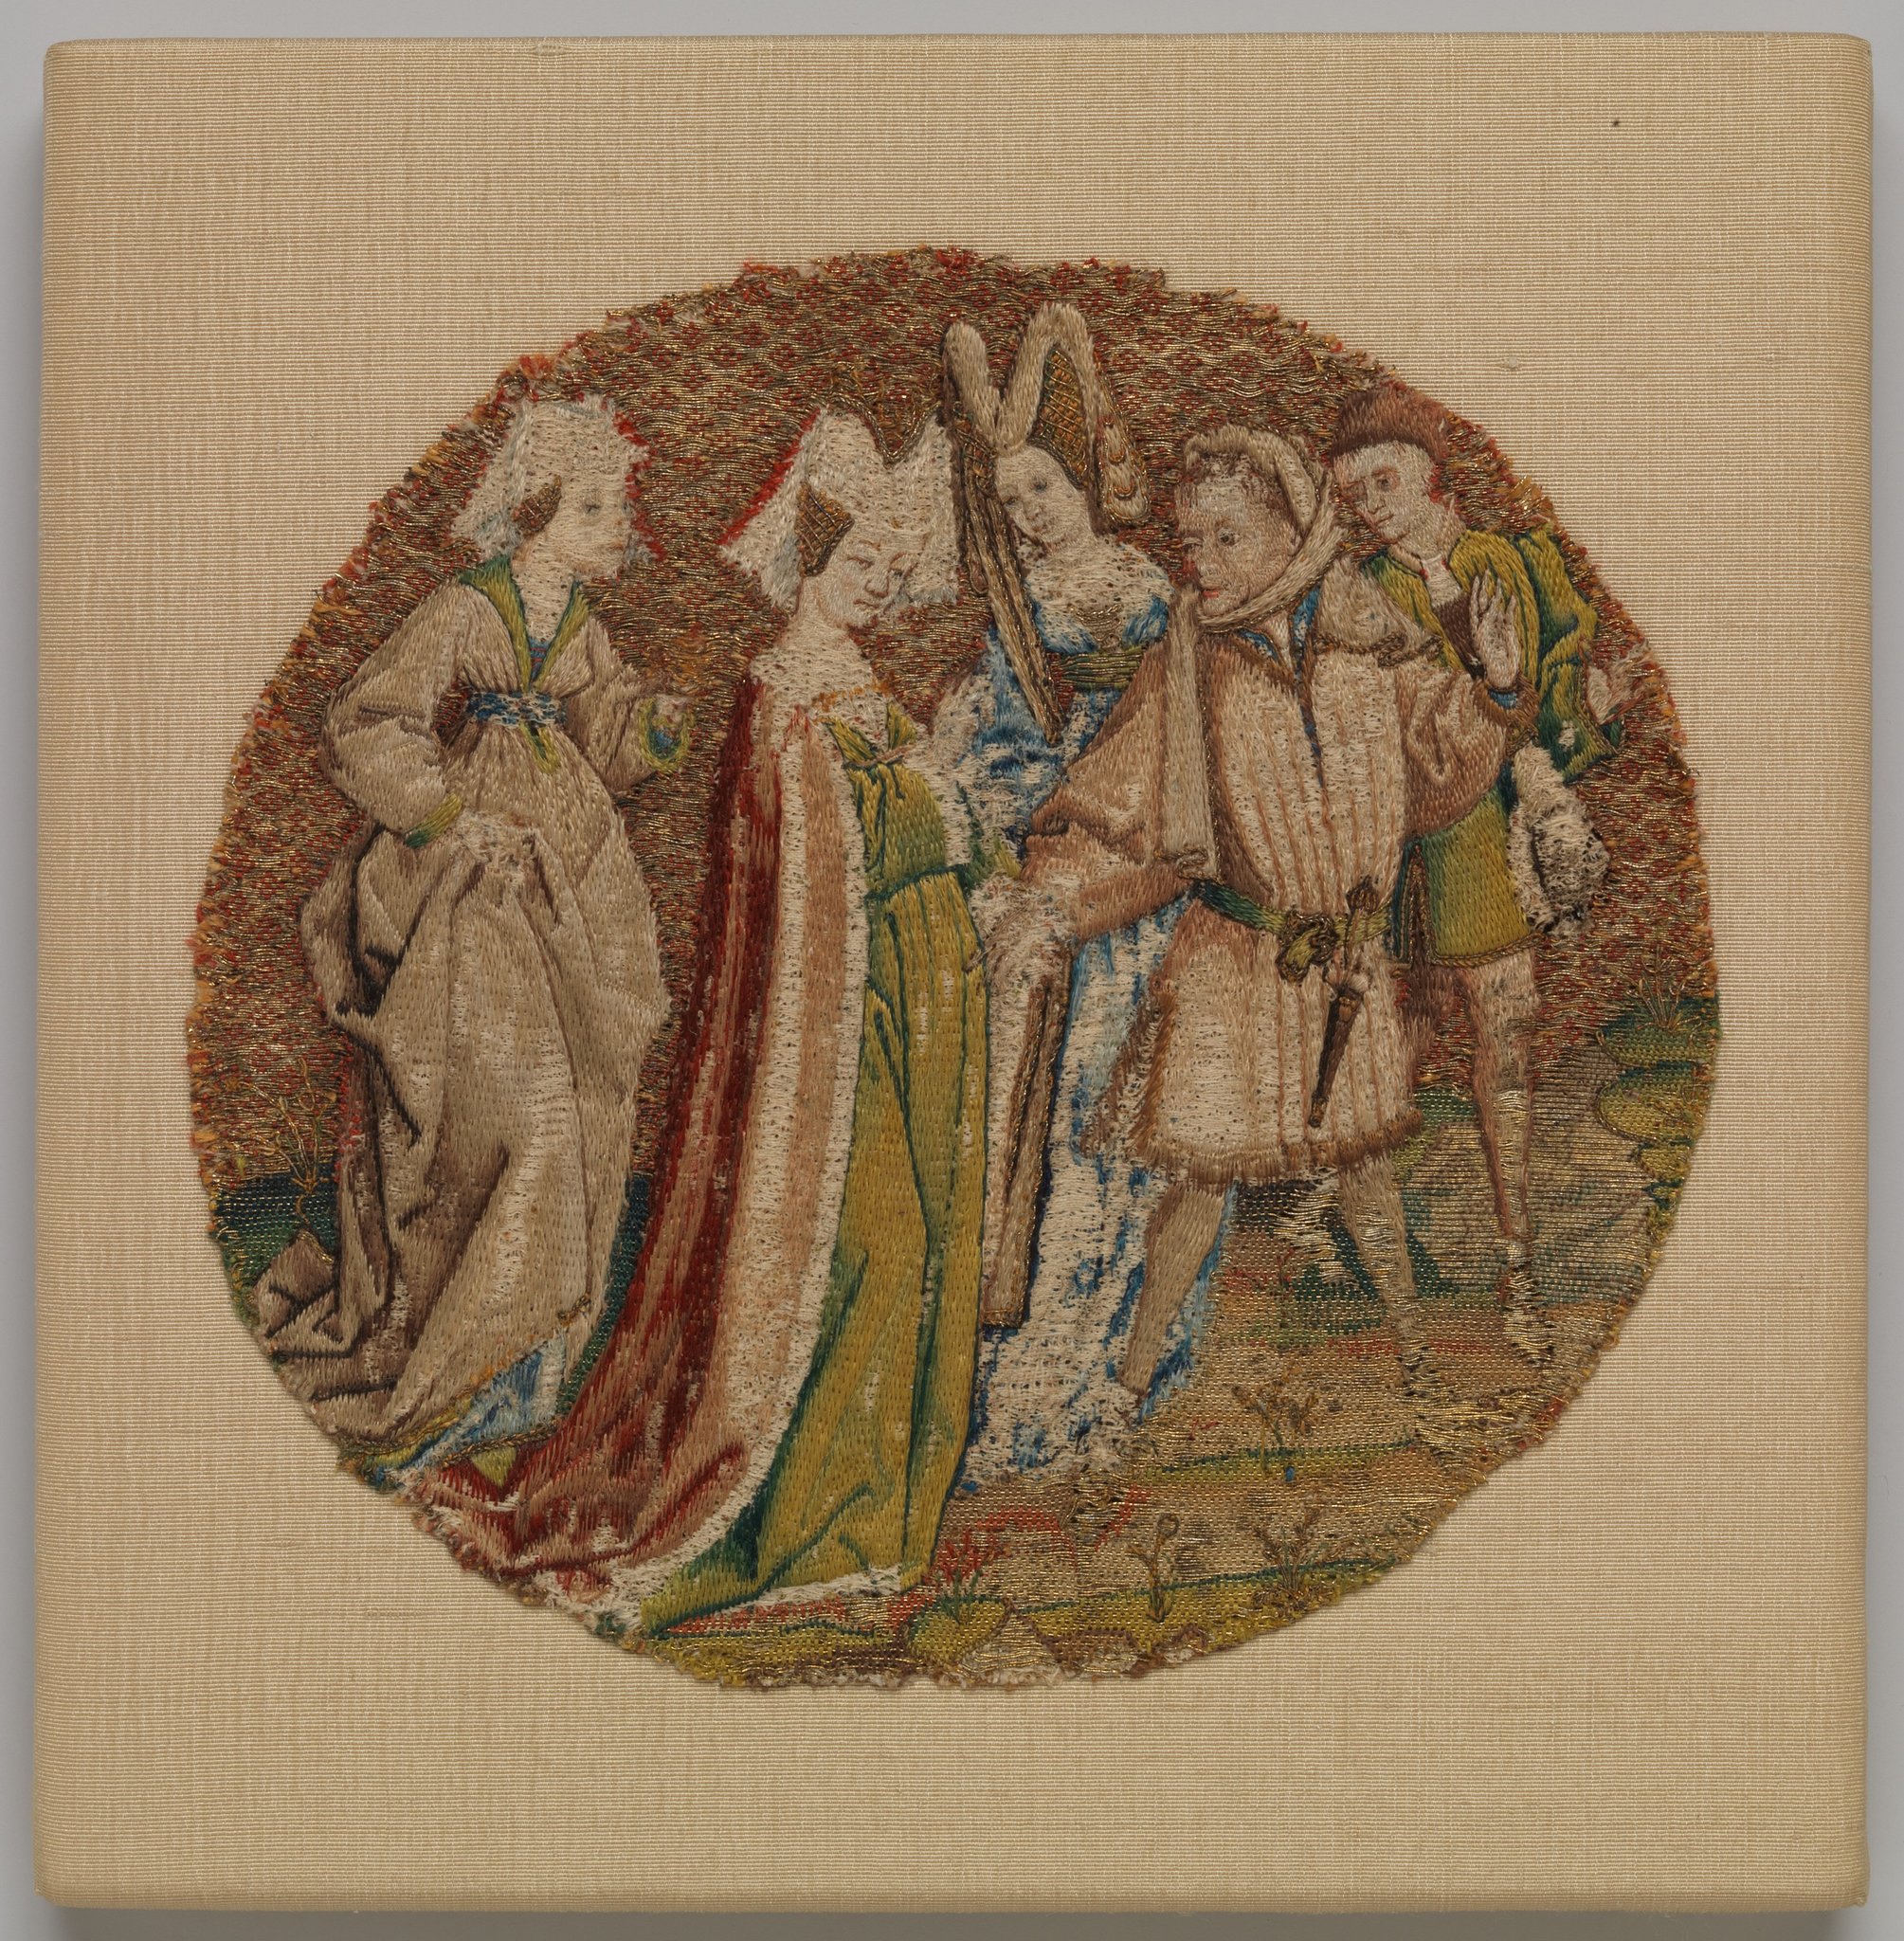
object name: roundel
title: The Empress and Porphyrius Visit St. Catherine in Prison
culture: south netherlandish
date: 1430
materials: linen, metal thread, silk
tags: men,women,saint catherine